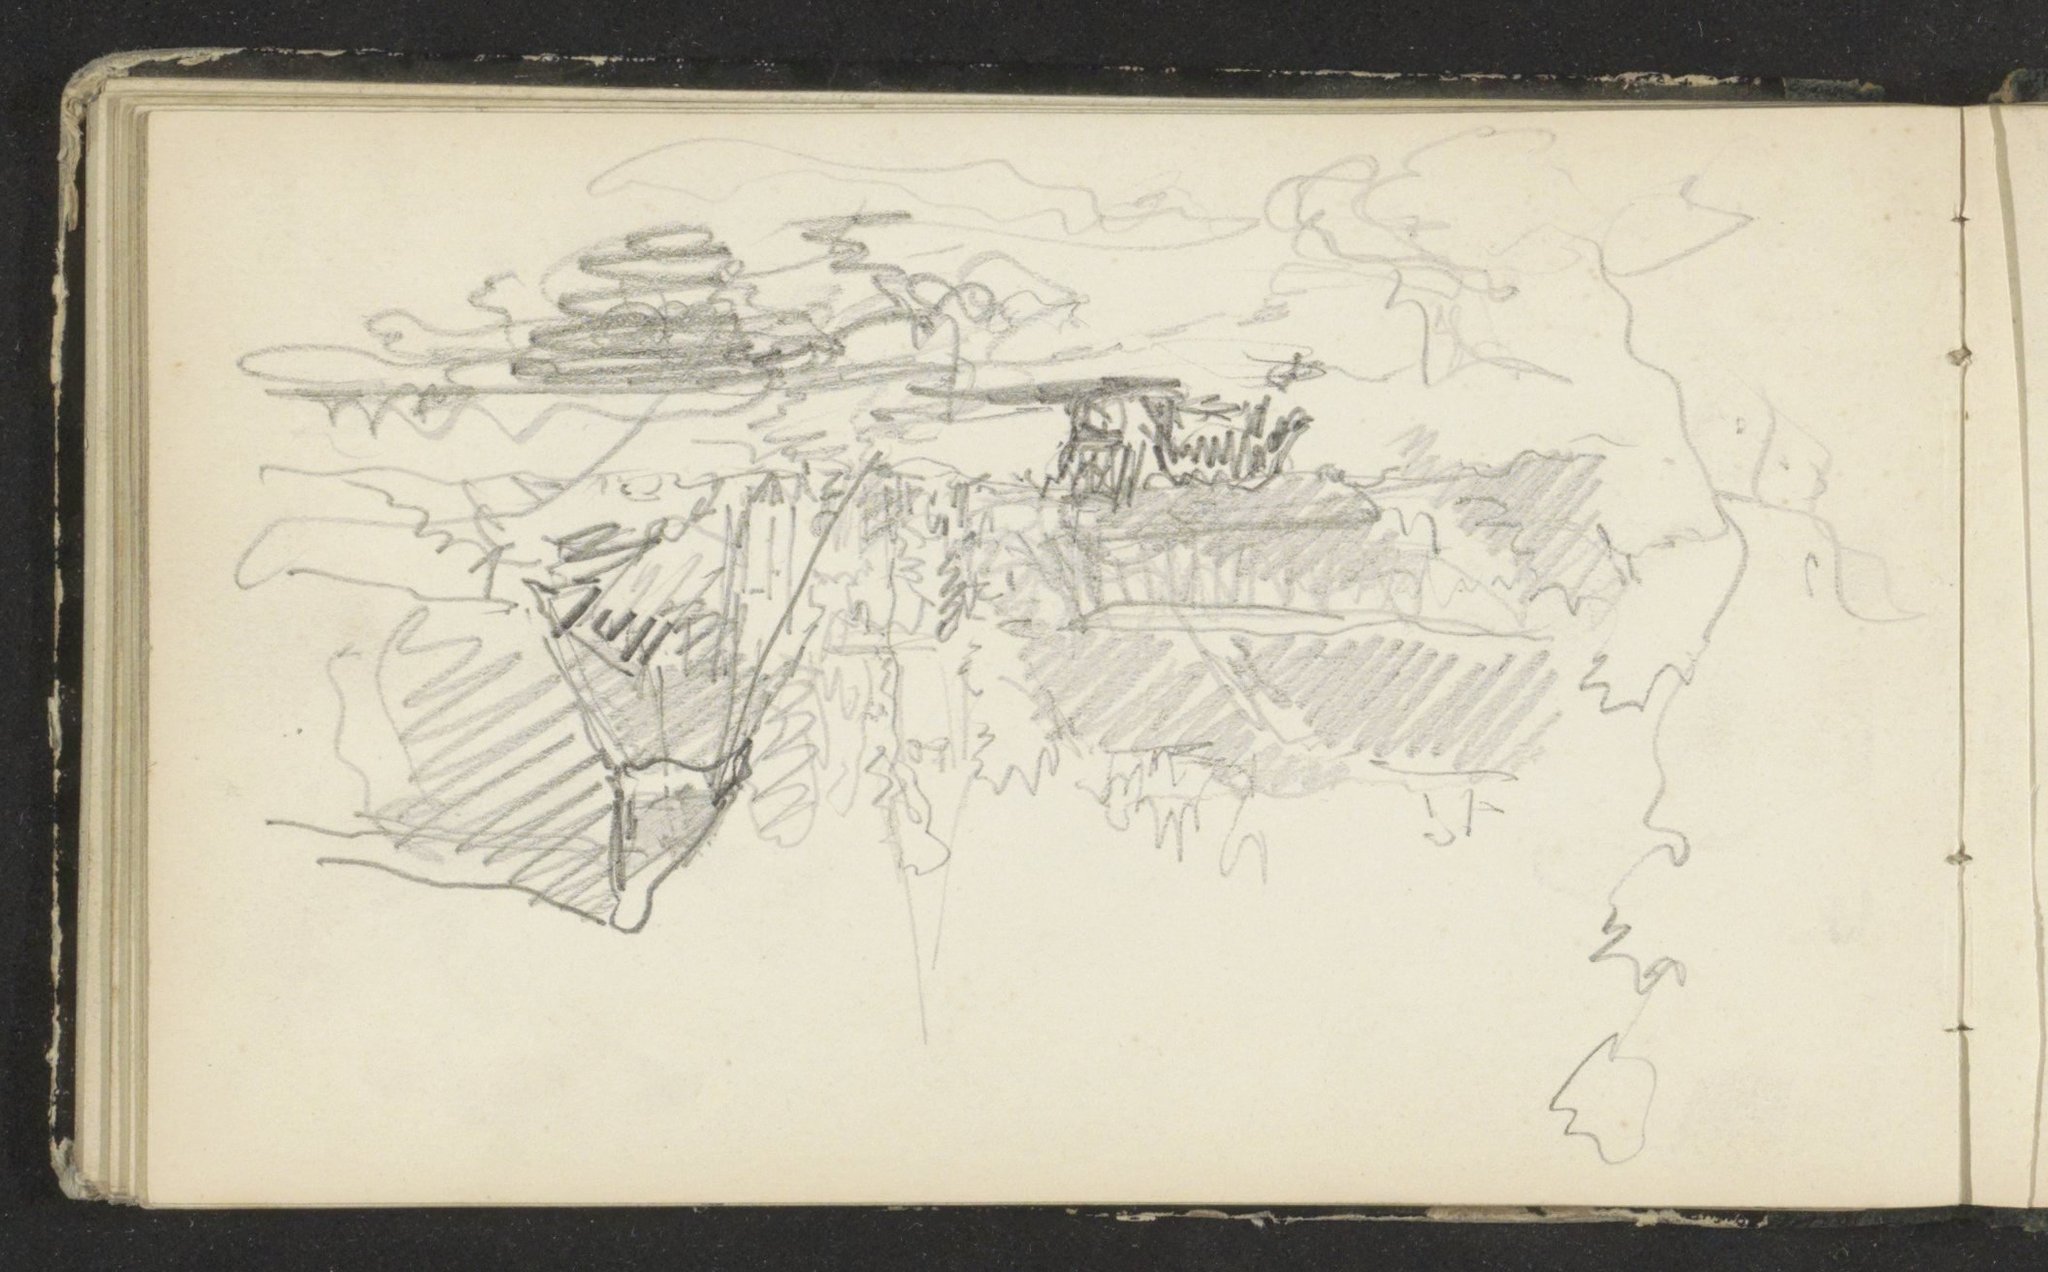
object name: sketchbook leaf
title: Gezicht op een dorp met een kerktoren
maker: maria vos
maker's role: draughtsman, painter, print maker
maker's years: 1824-1906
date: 1834-1906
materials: paper, pencil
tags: city-view, and landscape with man-made constructions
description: Blad 34 verso uit een schetsboek met 46 bladen.